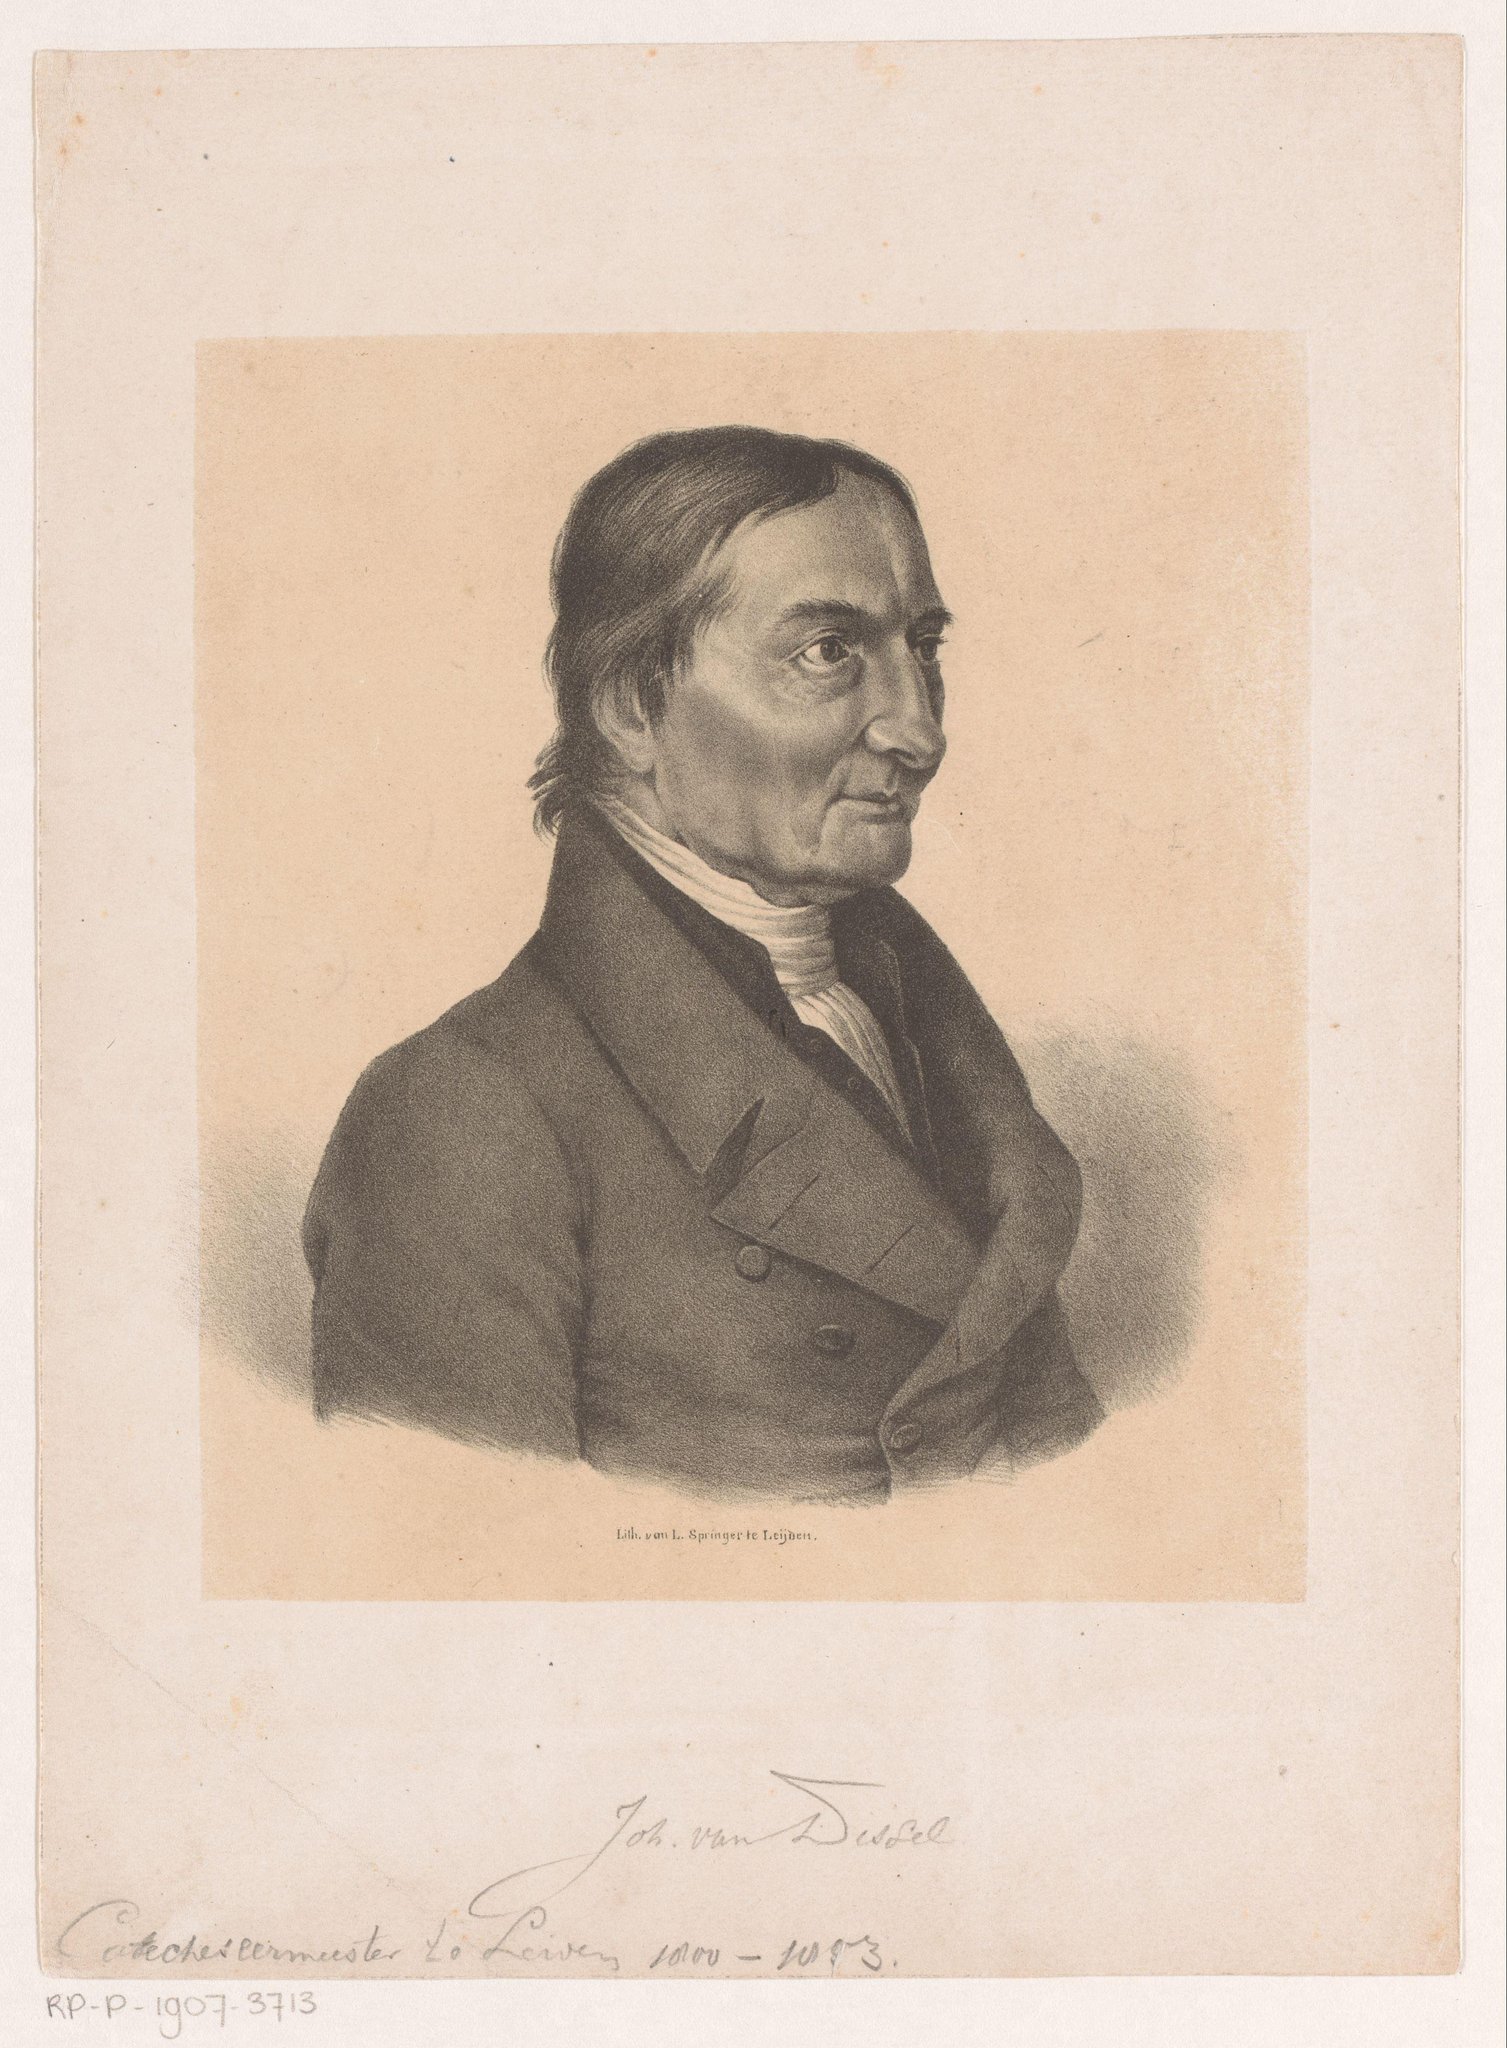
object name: print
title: Portret van Johan van Diesel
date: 1831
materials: paper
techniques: tone lithography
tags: johan van dissel, historical persons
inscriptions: collector's mark: Lugt 2228